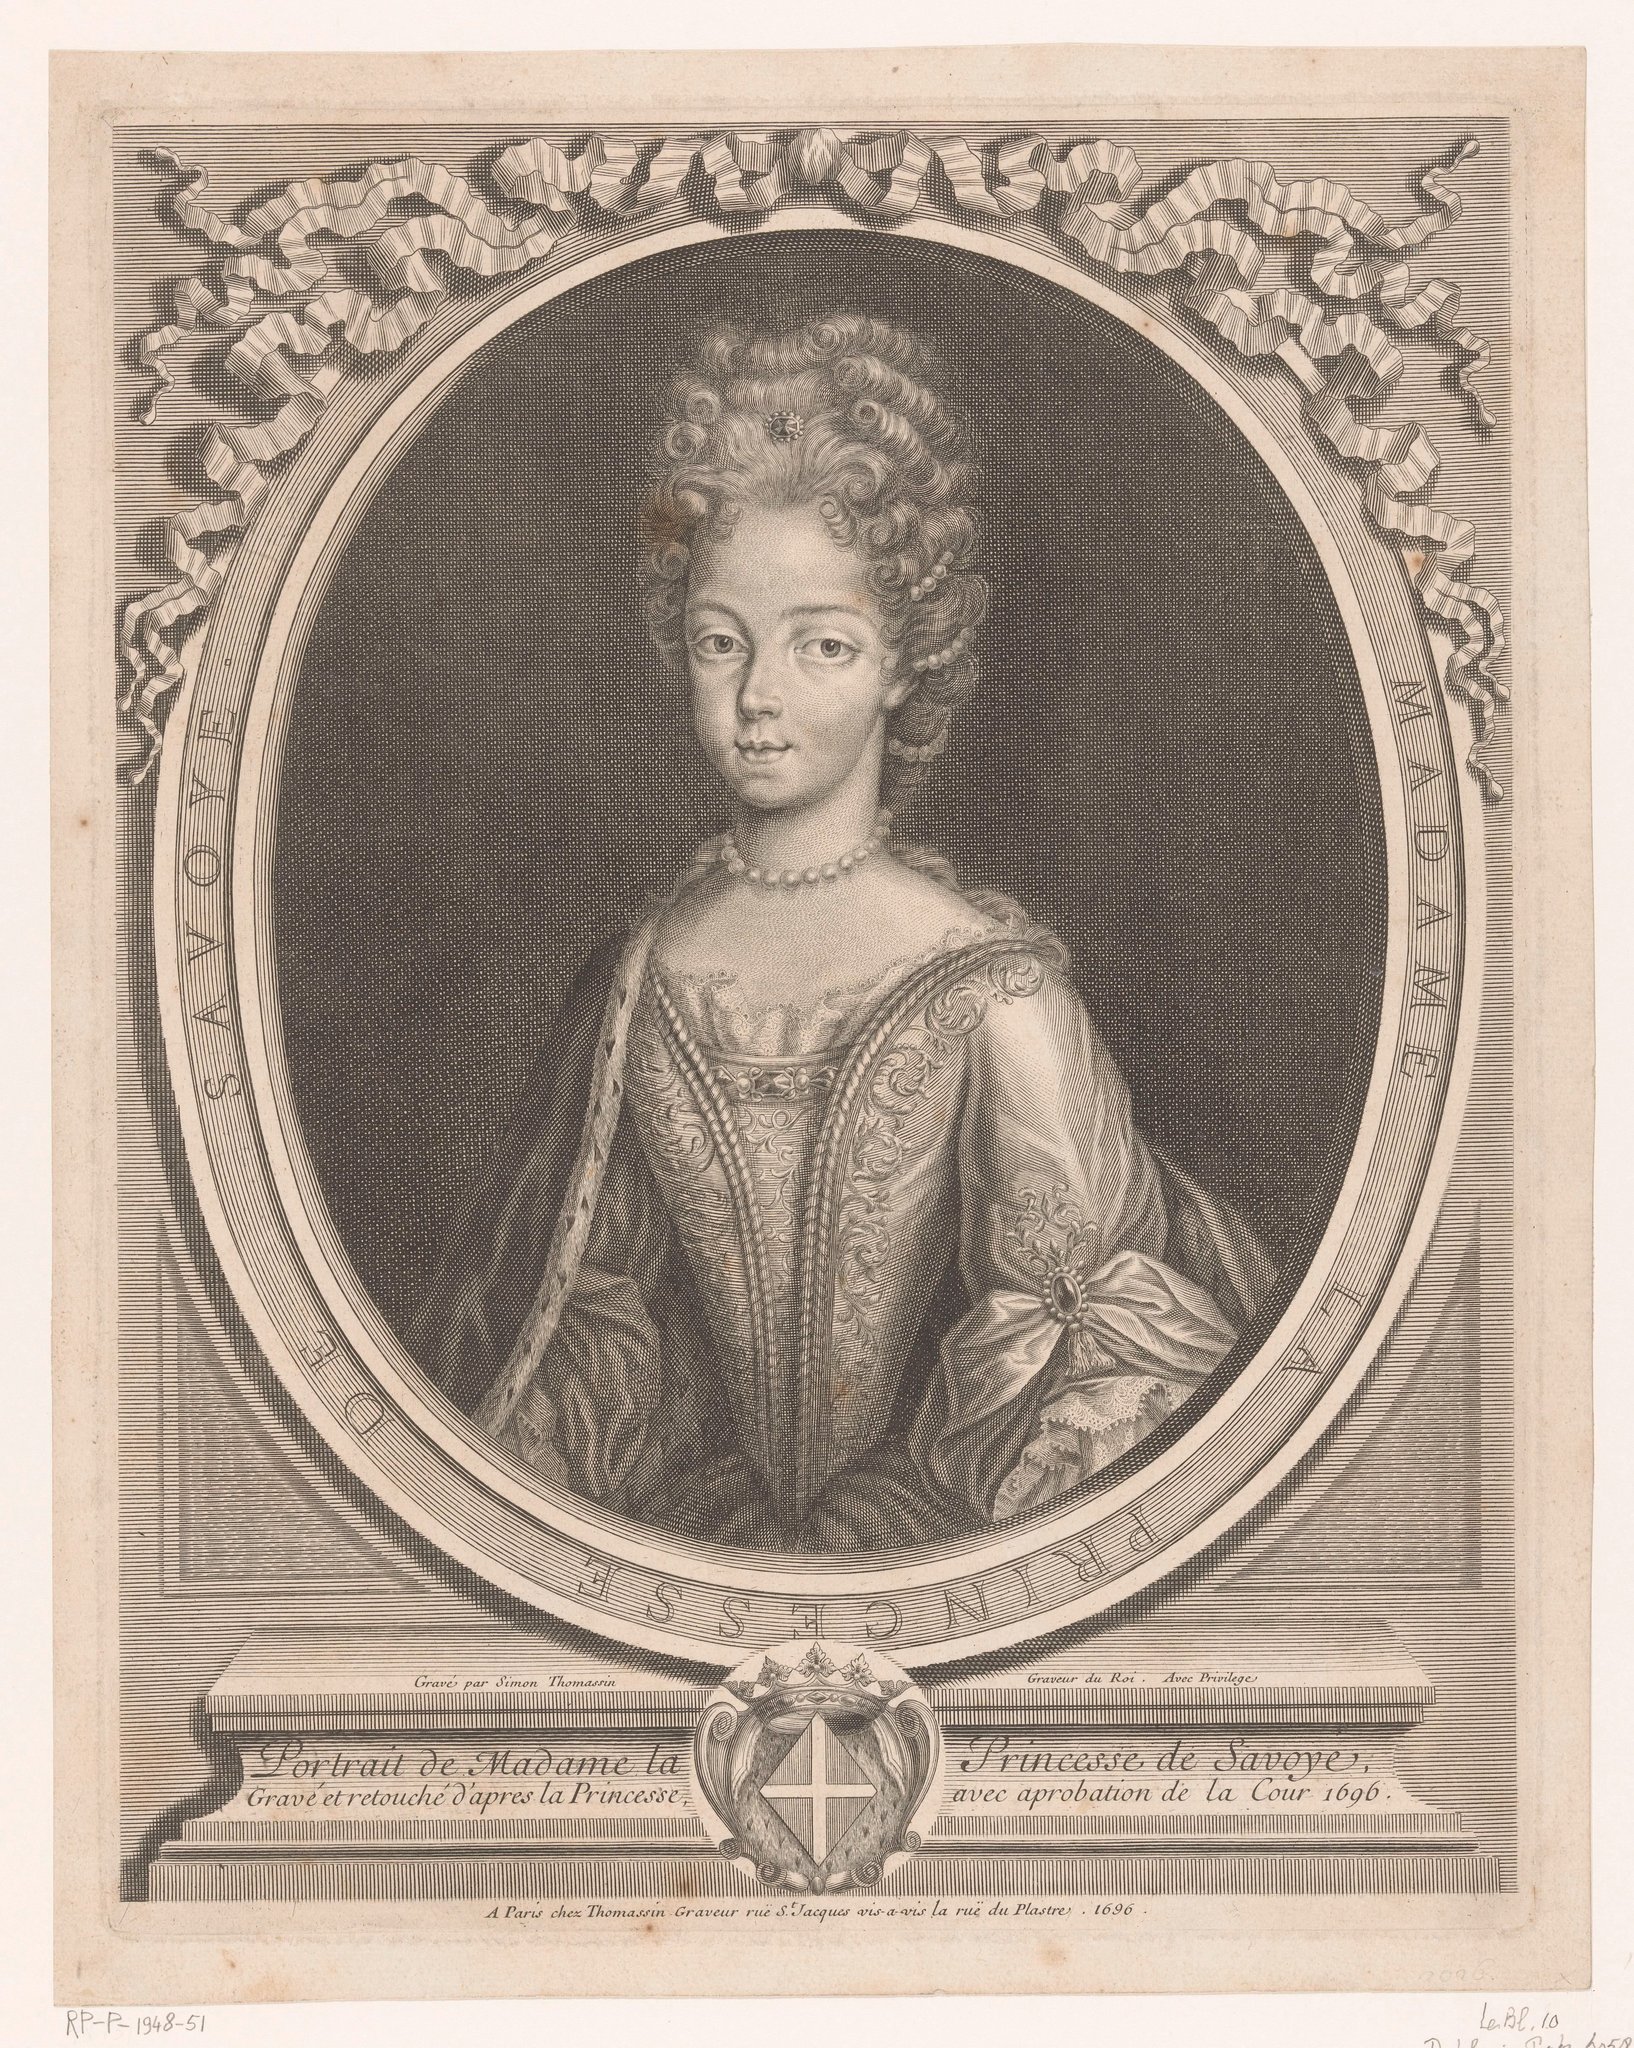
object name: print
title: Madame la Princesse de Savoye.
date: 1696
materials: paper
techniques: engraving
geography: france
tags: historical persons, ruler, sovereign - bb - female ruler, ornaments, jewels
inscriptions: collector's mark: Lugt 151, collector's mark: Lugt 2228